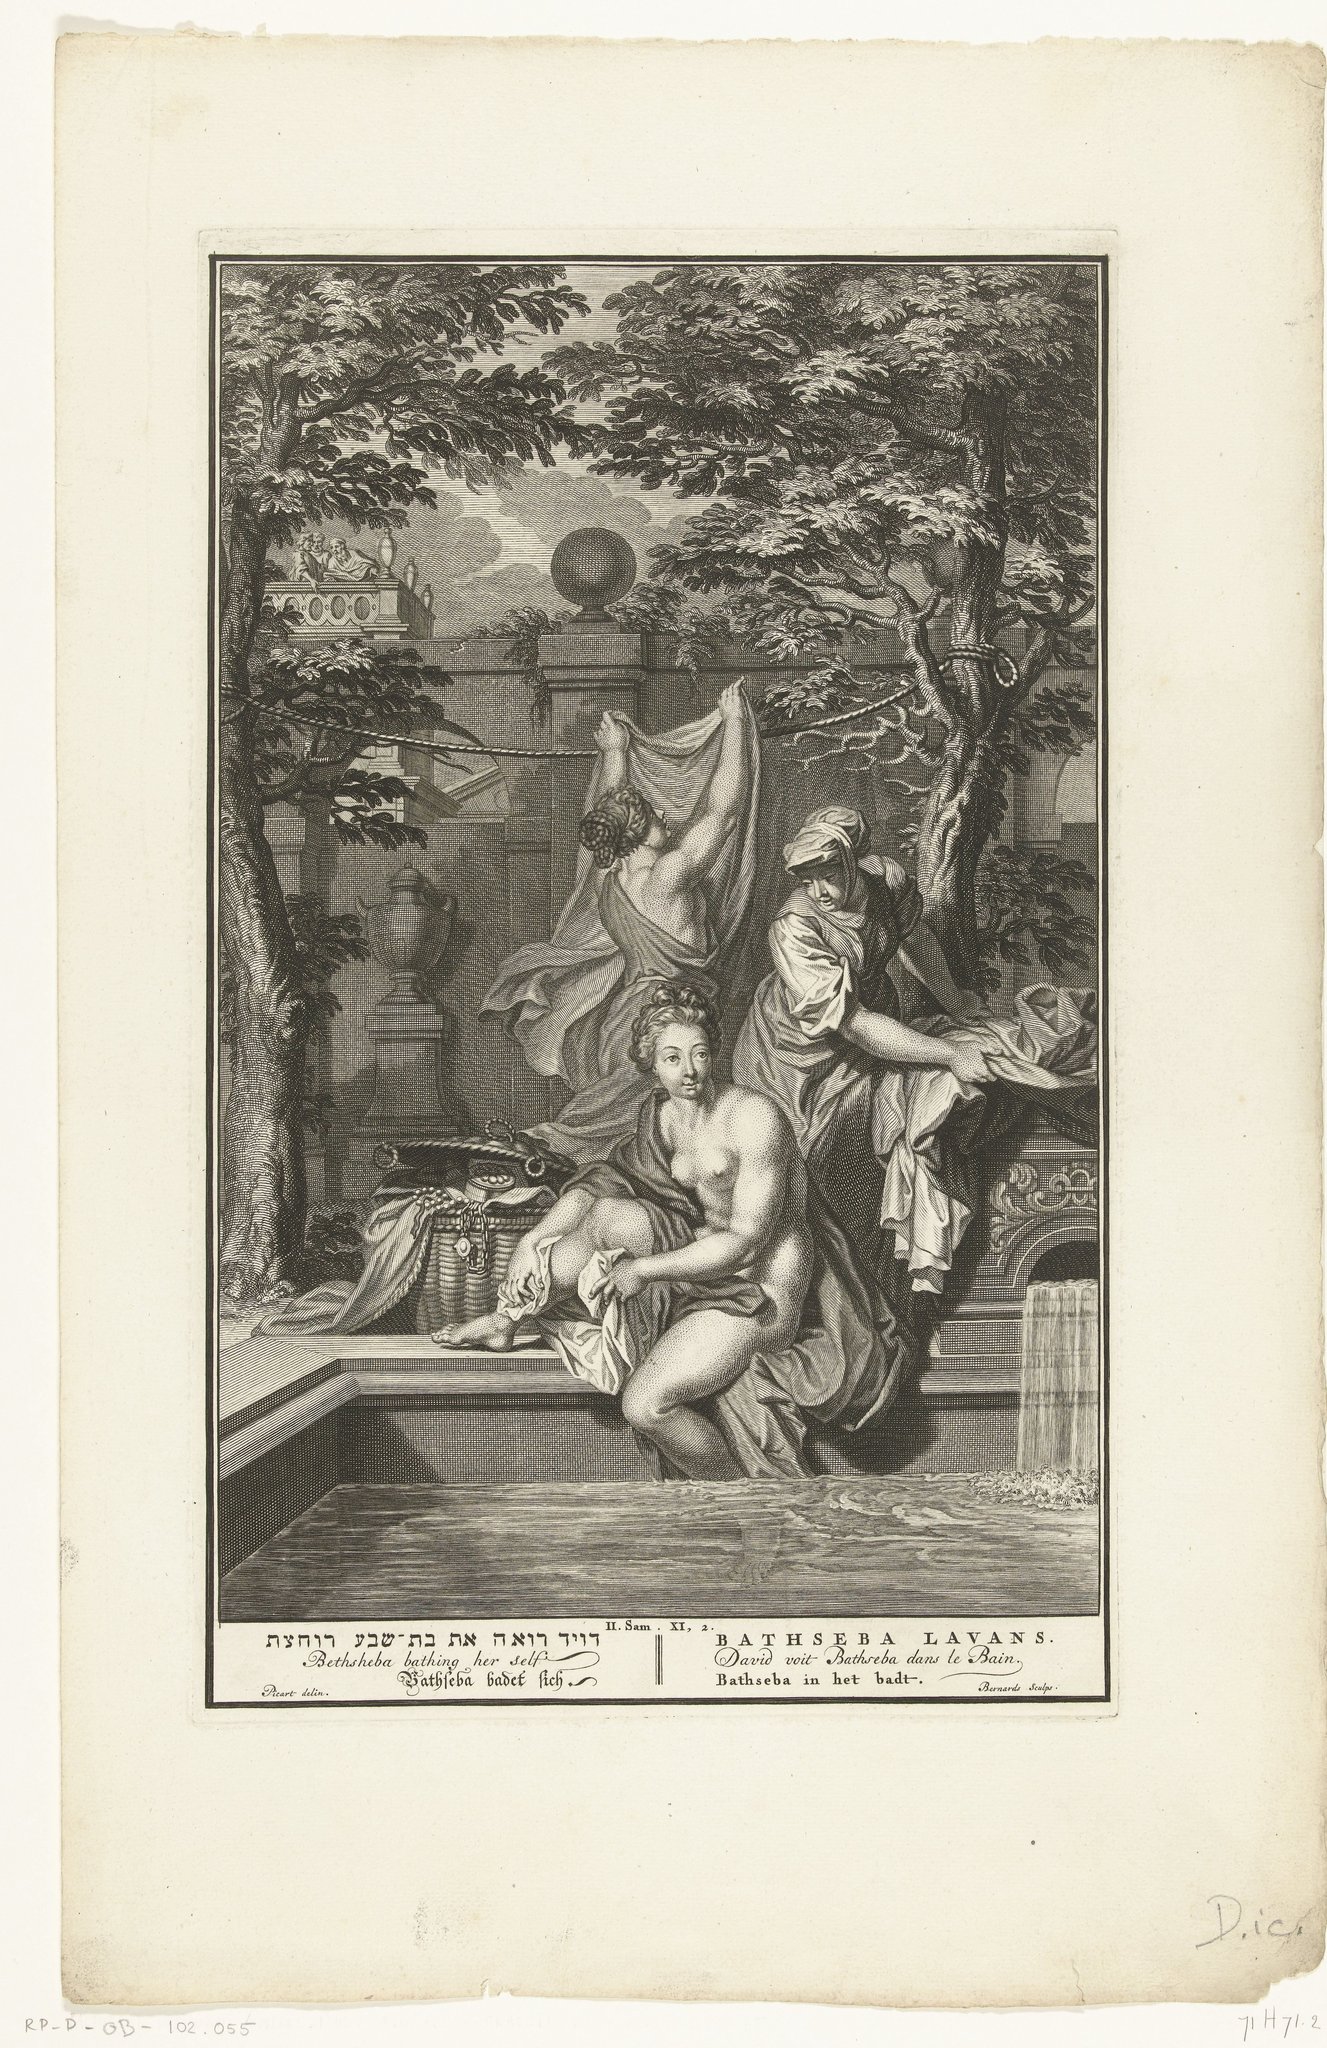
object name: print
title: Batheseba in het badt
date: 1711-1720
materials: paper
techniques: engraving, etching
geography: amsterdam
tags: david, from the roof (or balcony) of his palace, sees bathsheba bathing, bathsheba attended by servant(s)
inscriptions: collector's mark: Lugt 2228, inscription: ‘Utrechts Fundatie Huijs’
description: Batseba neemt een bad in de paleistuin van koning David. Twee dienstmeisjes helpen haar. De ene reikt haar een handdoek aan, de andere hangt een doek op de waslijn. Vanuit zijn balkon bekijkt David de scène.